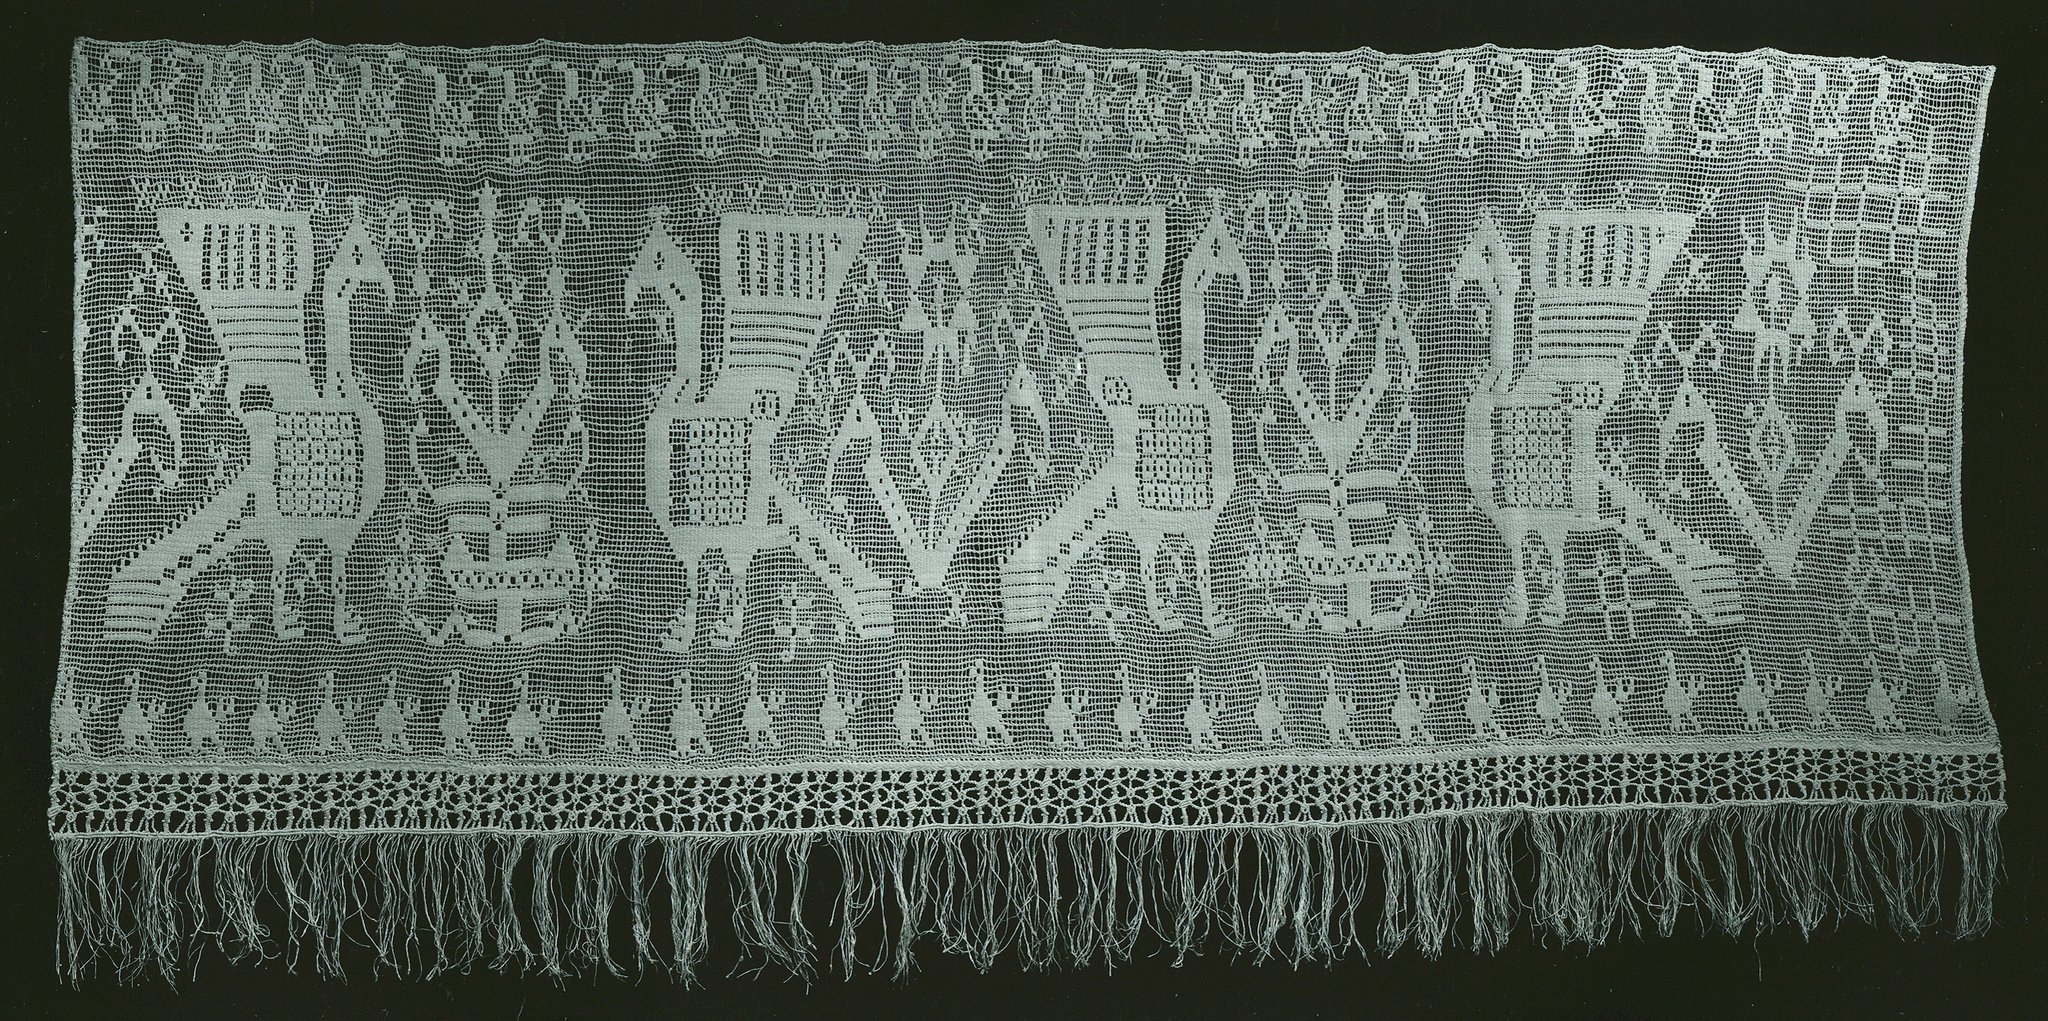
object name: textile border fragment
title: Border Fragment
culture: italian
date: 1601-1800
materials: linen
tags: birds